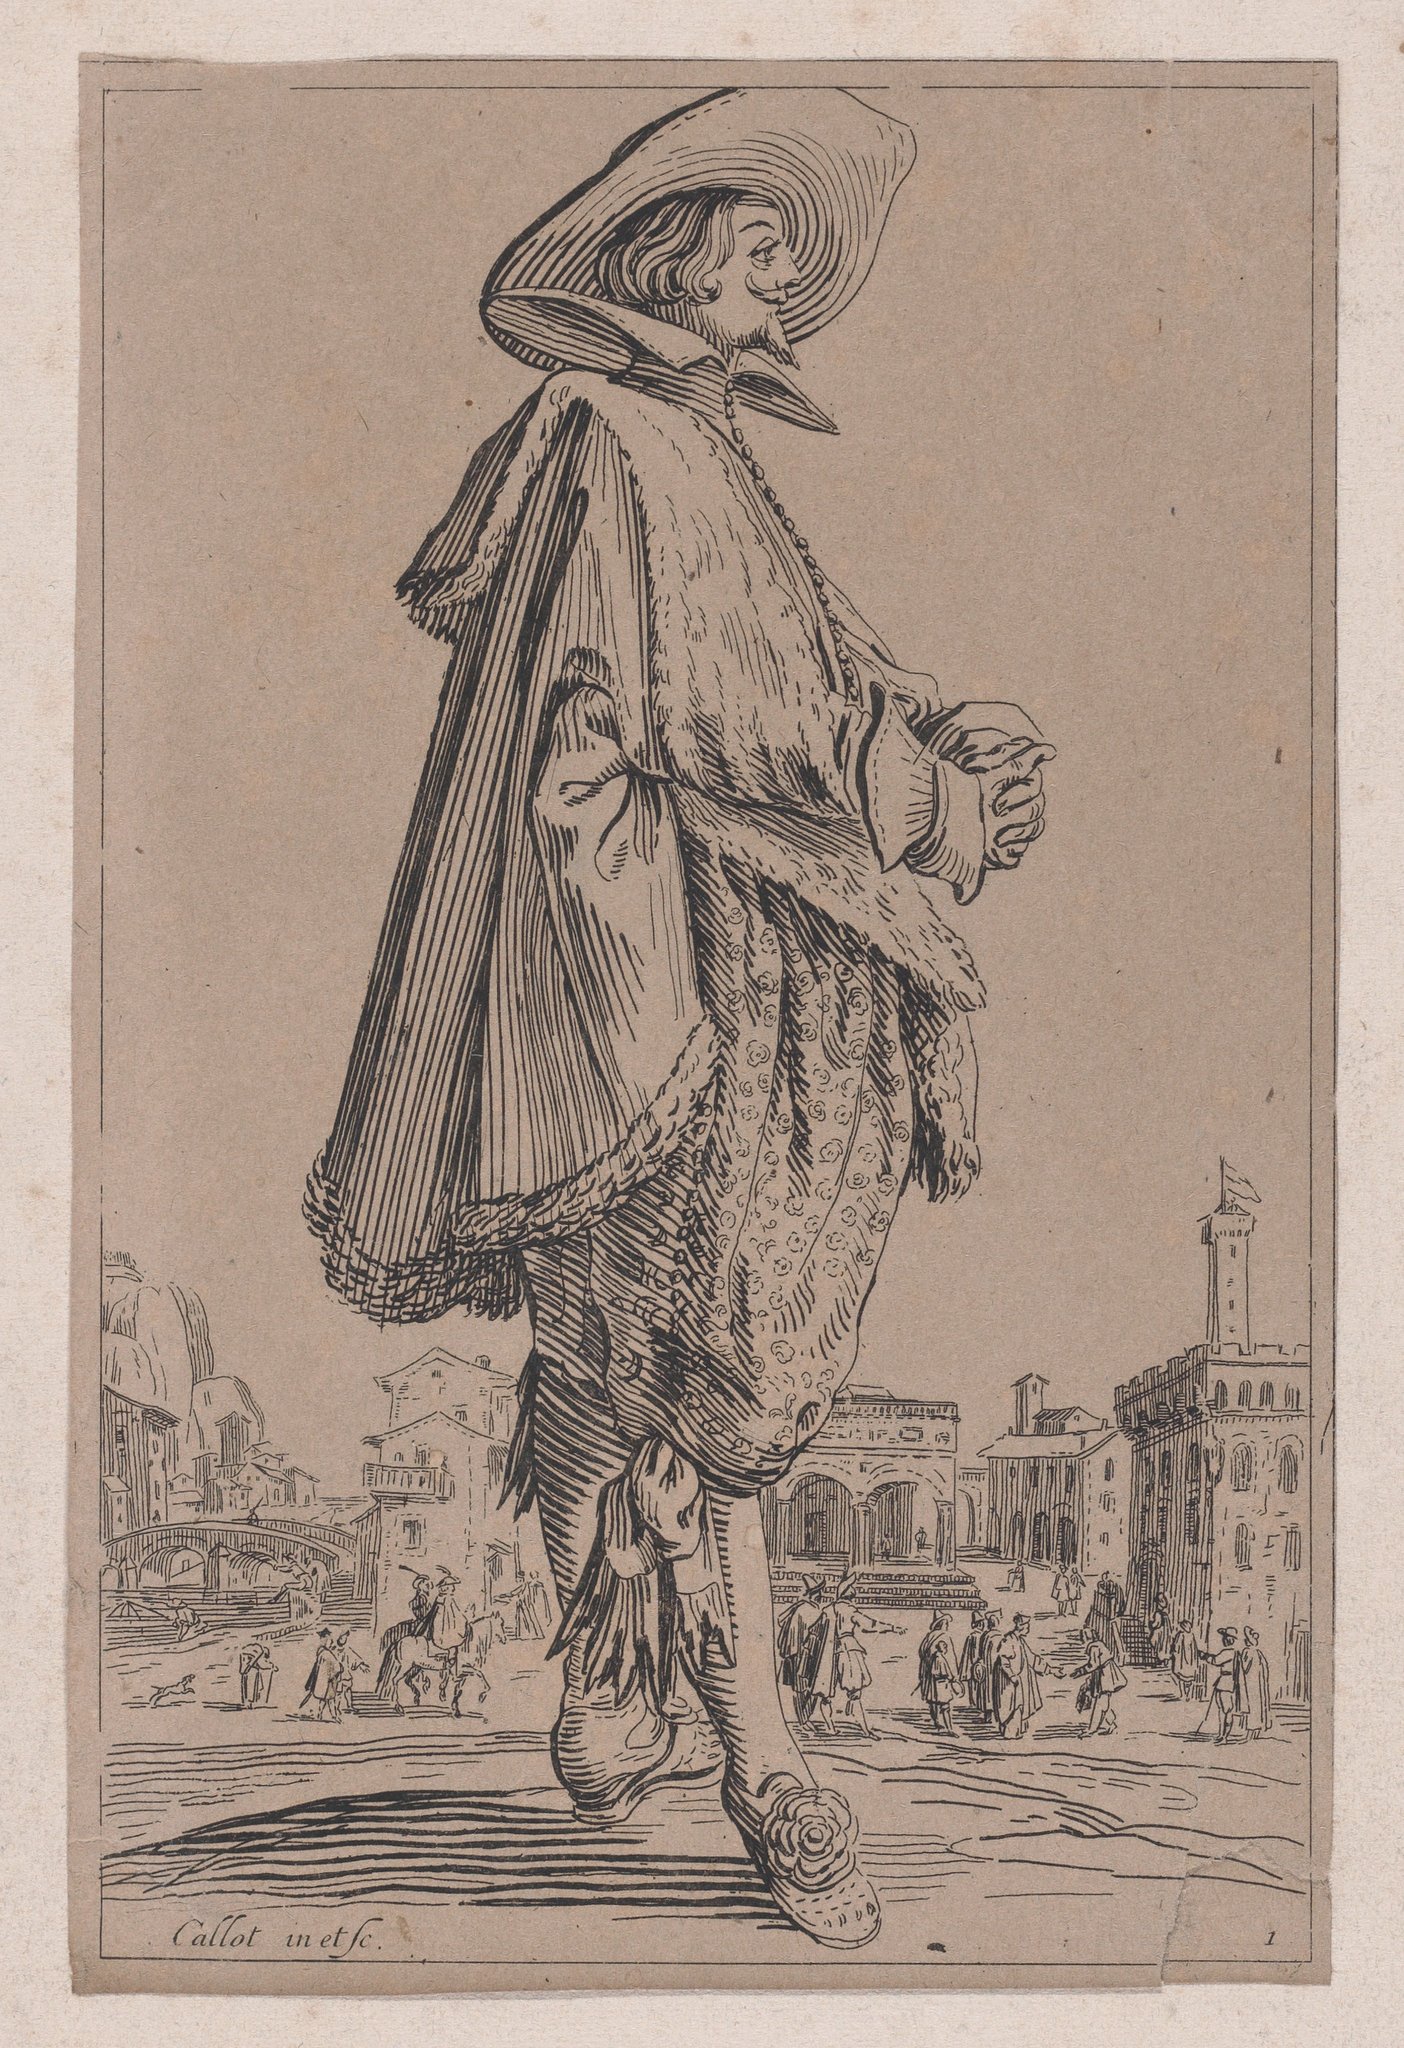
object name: print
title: Copy of Le Gentilhomme aux Mains Jointes (The Gentleman with his Hands Joined), from "La Noblesse" (The Nobility)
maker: Anonymous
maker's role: artist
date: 1601-1700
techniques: etching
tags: men